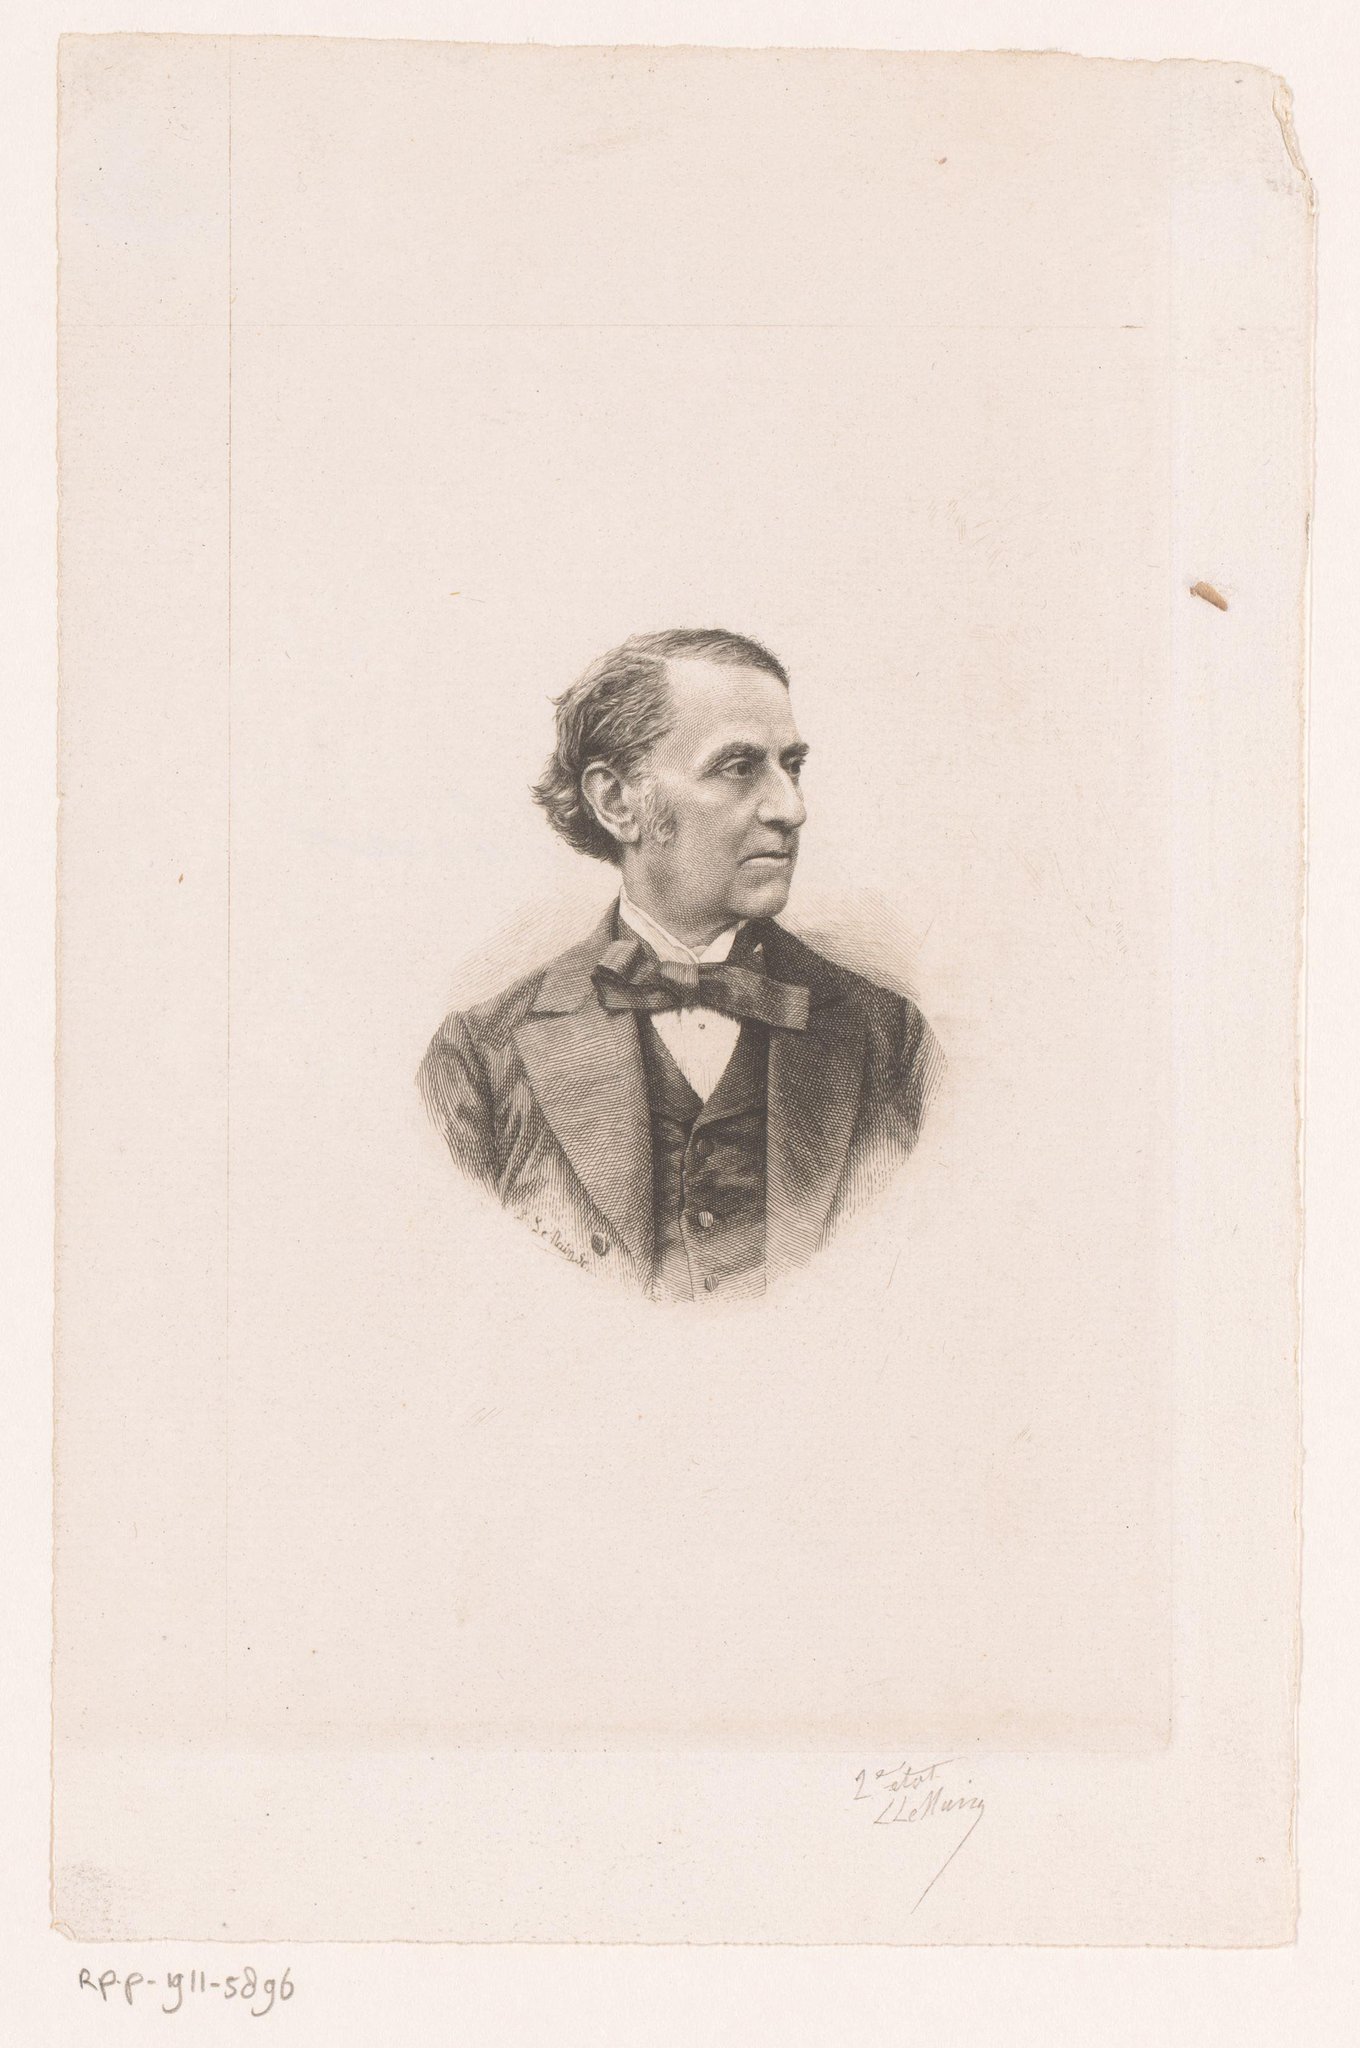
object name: print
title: Portret van Louis Blanc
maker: louis le nain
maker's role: print maker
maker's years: 1851-1939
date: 1861-1911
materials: paper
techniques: etching, intaglio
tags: politician, adult man, historical persons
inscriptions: inscription: ‘2e etat LLe Nain’, collector's mark: Lugt 2228